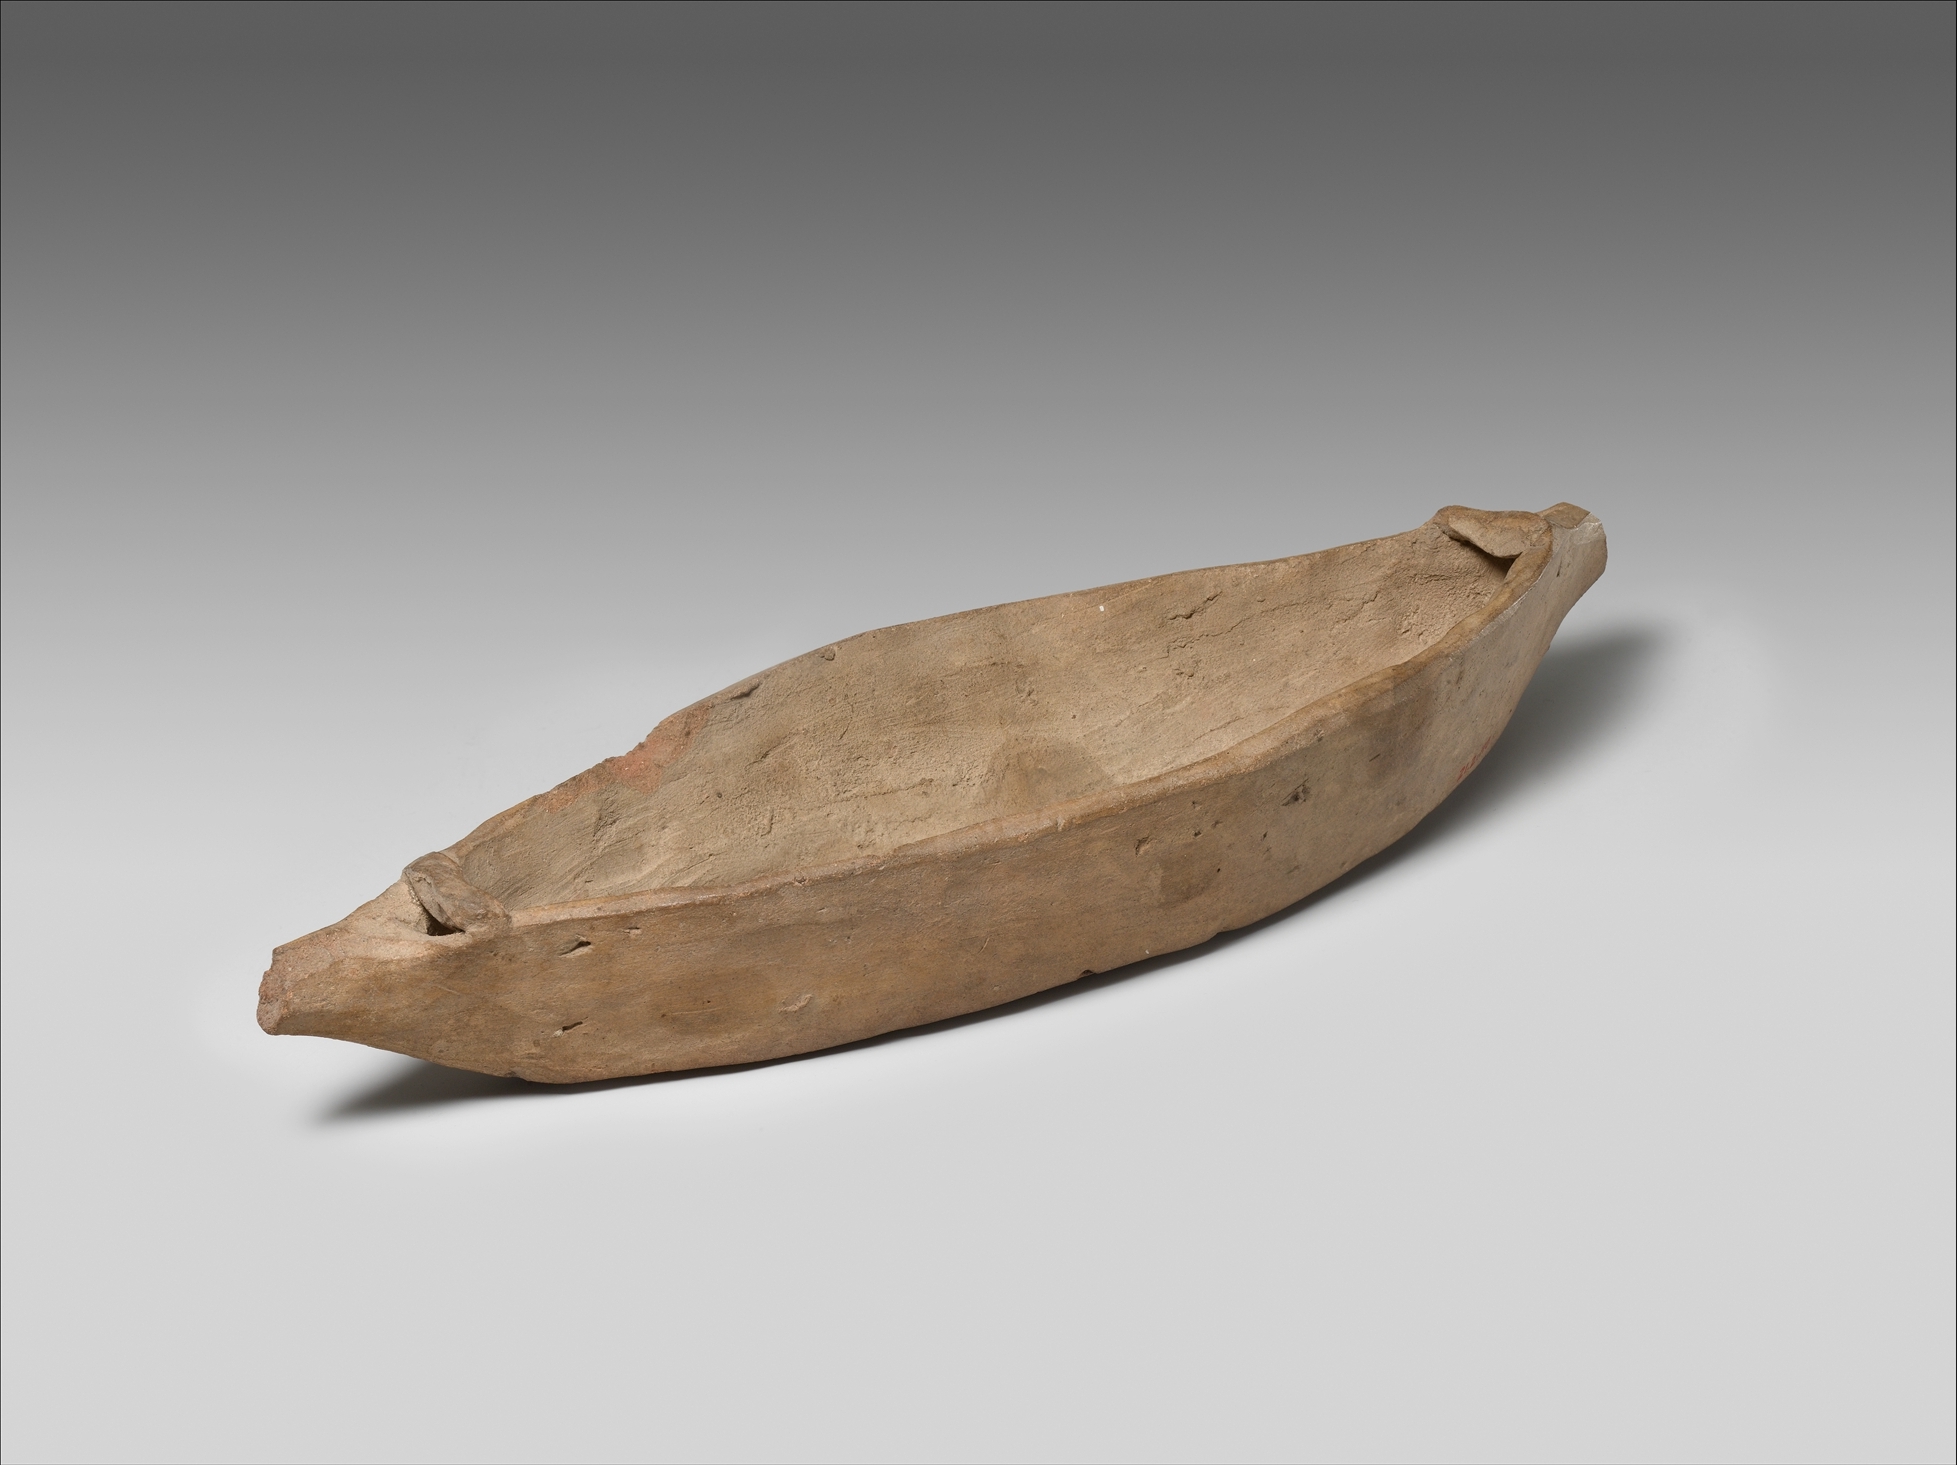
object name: model boat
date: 3650-3300 BCE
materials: pottery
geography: egypt